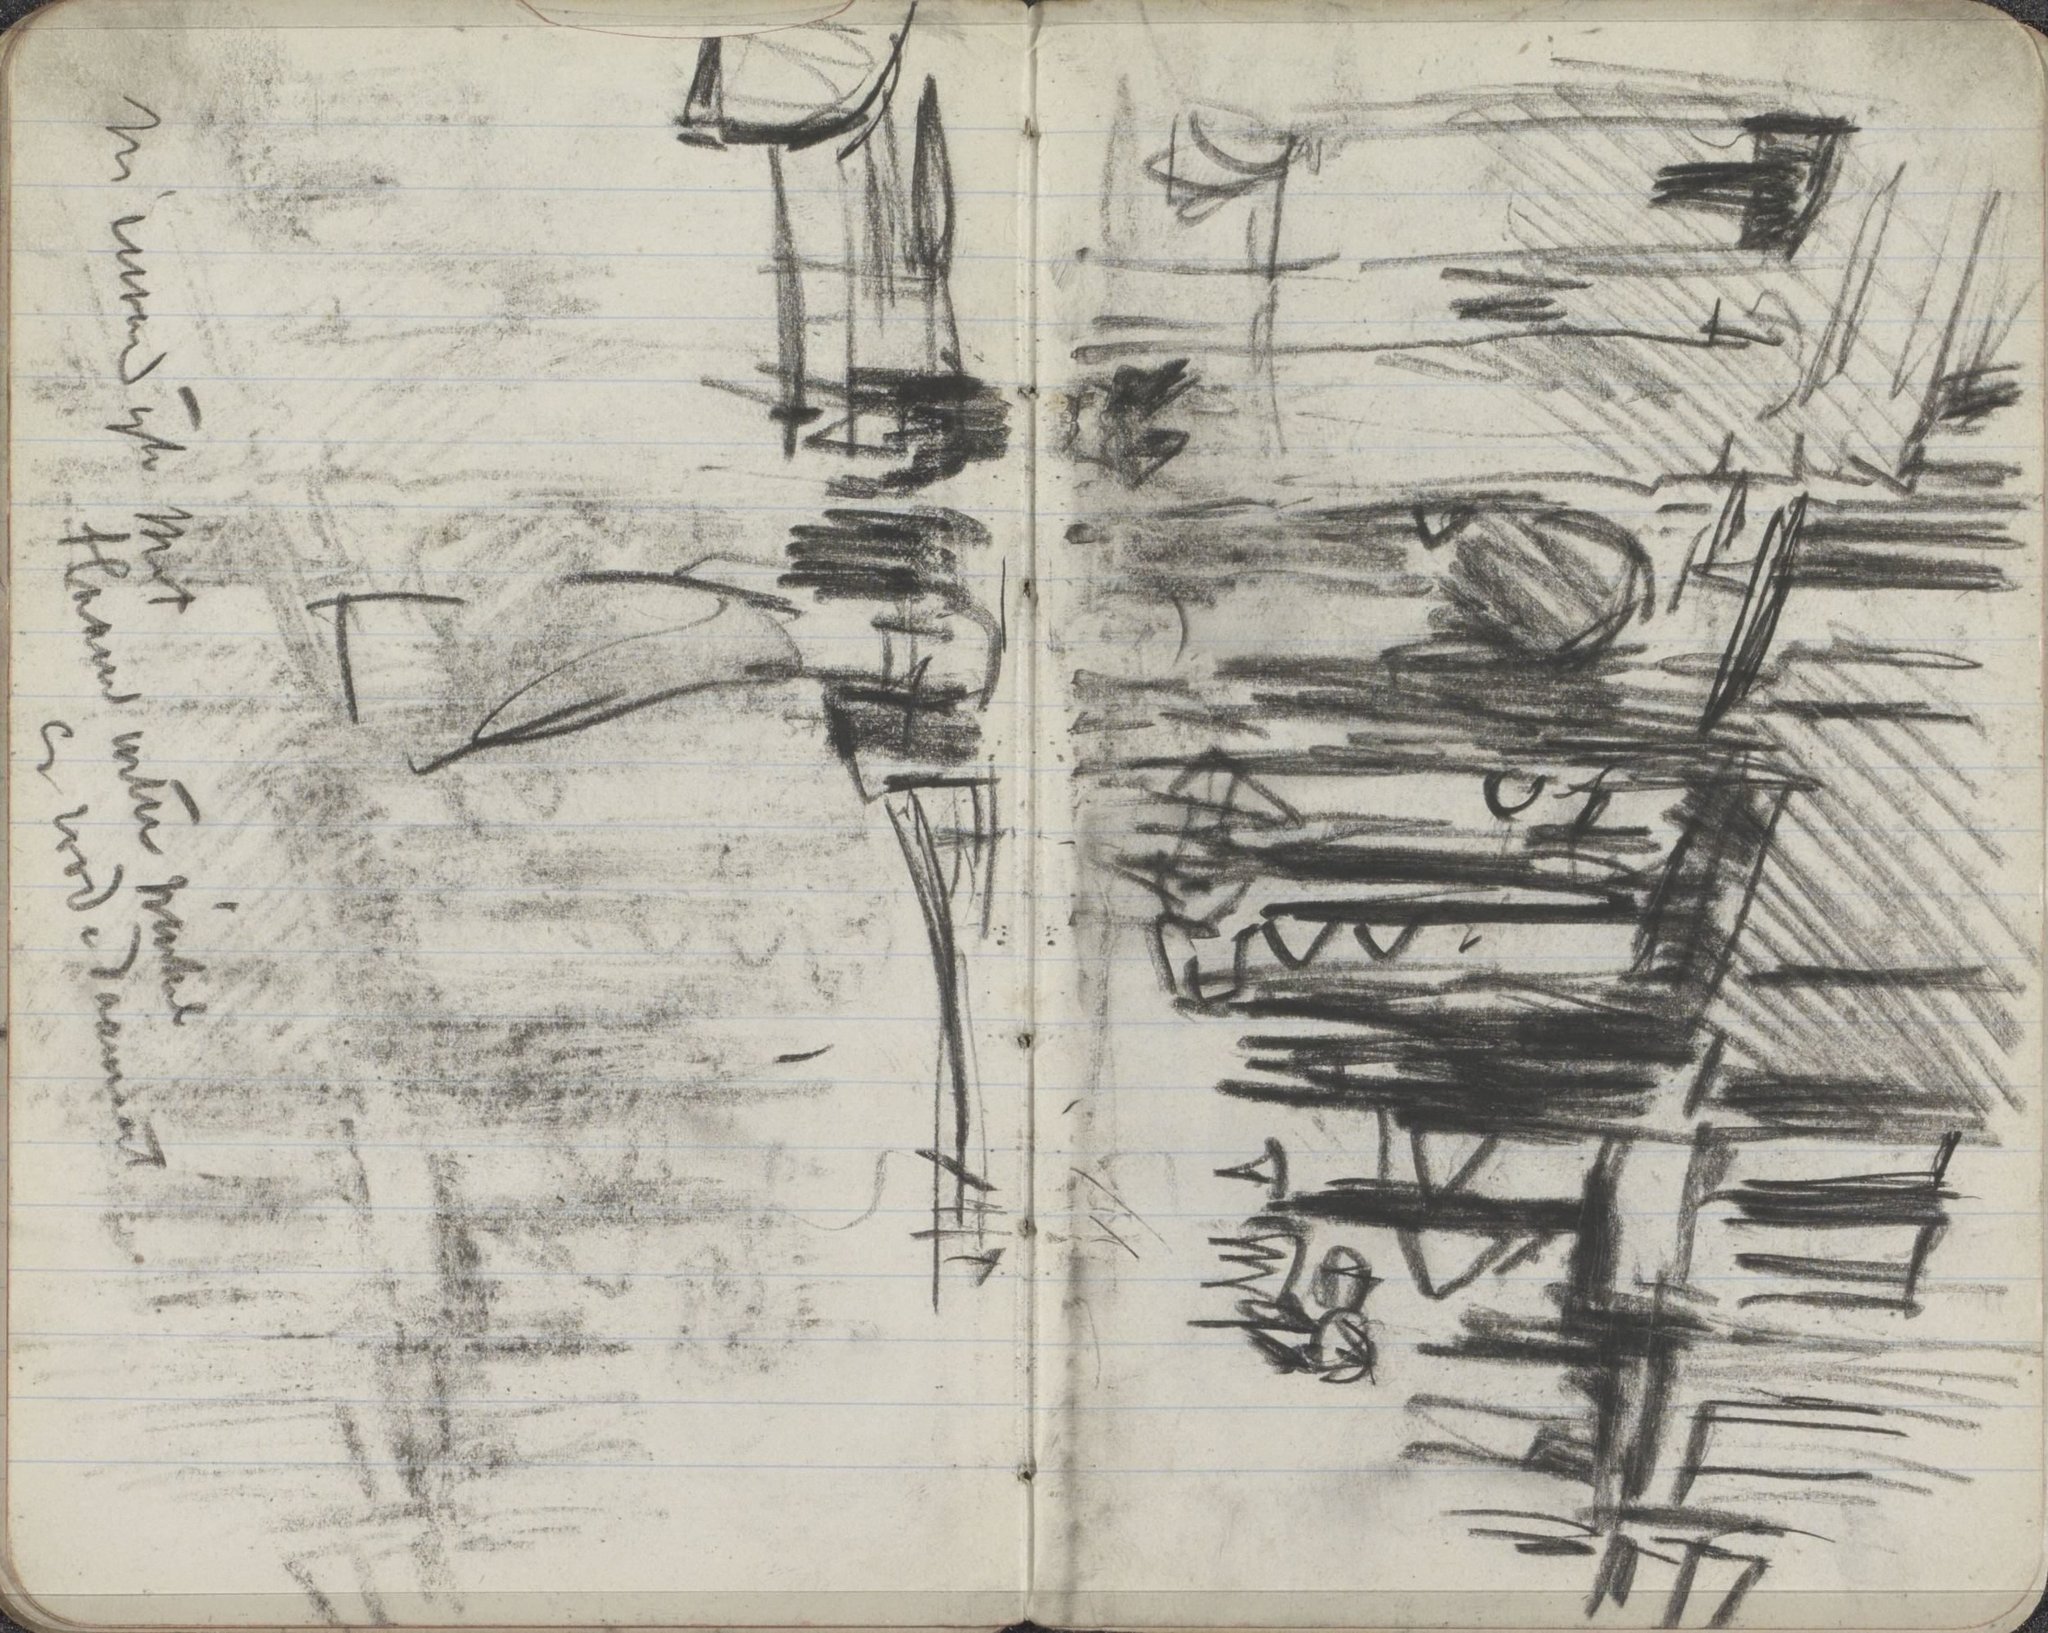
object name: sketchbook leaf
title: Gezicht op de Nieuwendijk te Amsterdam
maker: george hendrik breitner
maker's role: draughtsman, painter, print maker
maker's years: 1857-1923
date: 1893-1898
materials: chalk, paper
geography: amsterdam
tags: shop, store, street (+ city(-scape) with figures, staffage)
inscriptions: annotation: ‘Nieuwendijk met/ [...] winkel/ en roode [...]’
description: Pagina 69 en pagina 70 uit een schetsboek met 38 bladen.